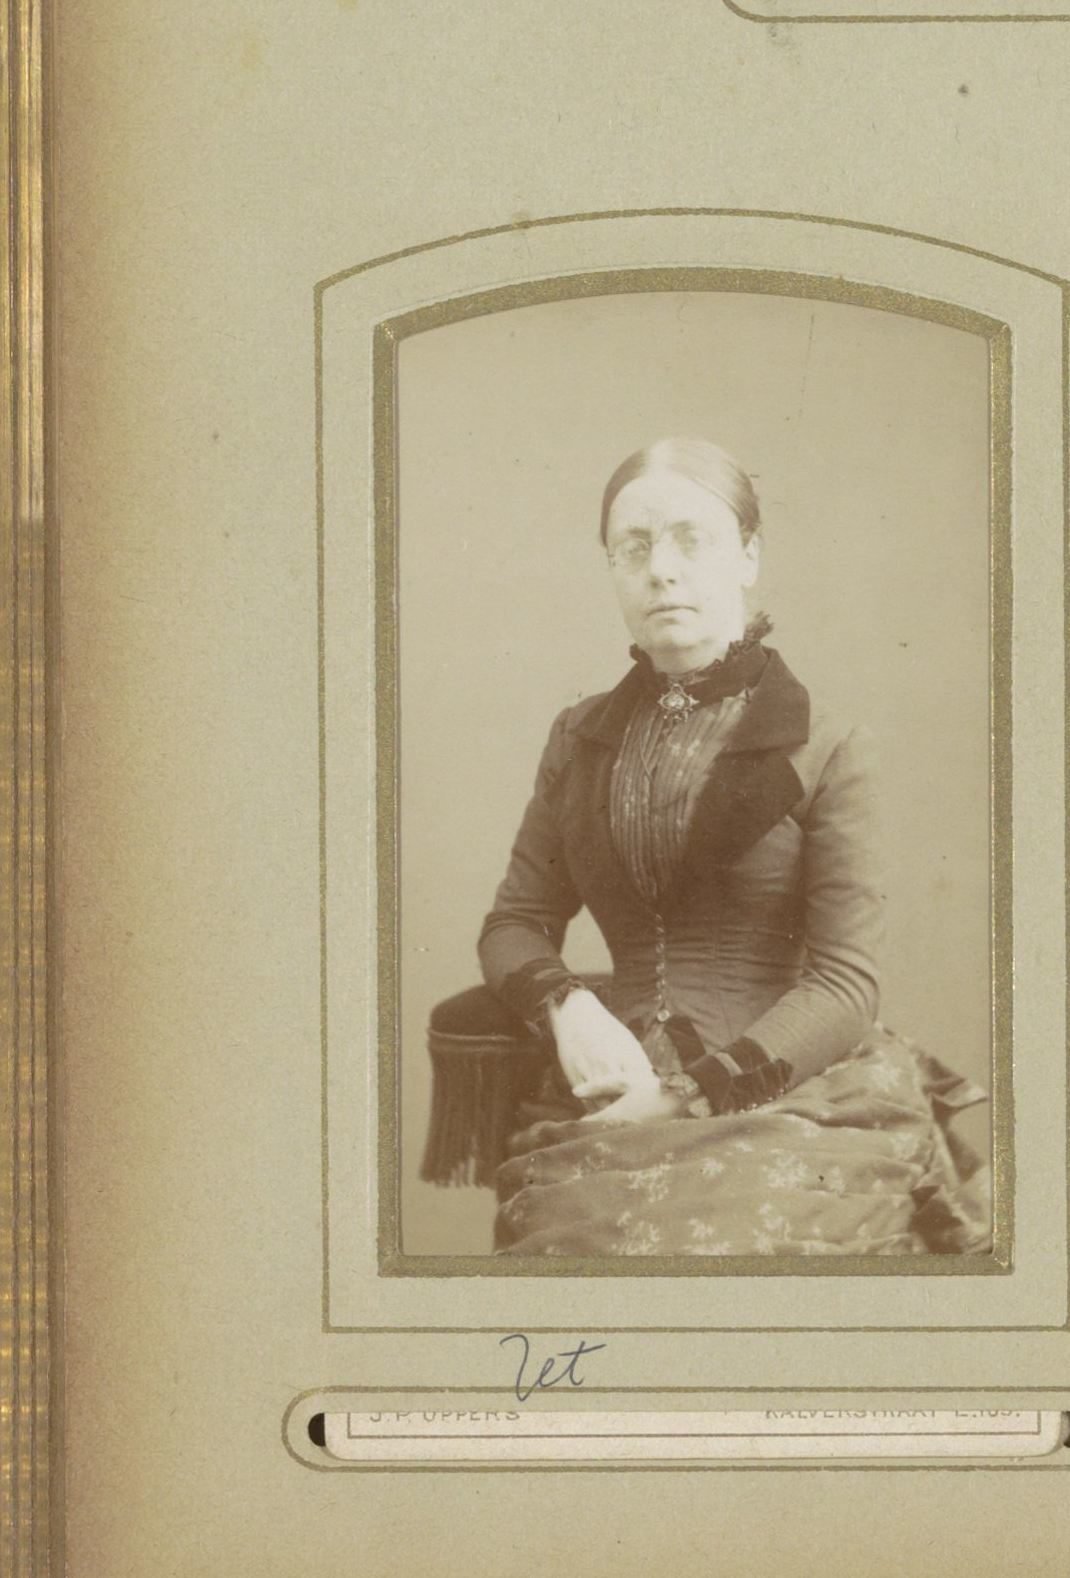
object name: photograph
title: Portret van Jet Boelen, zittend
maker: johannes petrus oppers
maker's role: fotograaf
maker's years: 1833-1890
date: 1869-1890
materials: cardboard, paper, photographic support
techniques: albumen print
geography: amsterdam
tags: adult woman, studio requisites ~ photographer, historical persons - bb - woman, amsterdam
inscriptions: address: ‘Kalverstraat, E 103 Amsterdam.’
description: Onderdeel van Fotoalbum van de familie Boelen.